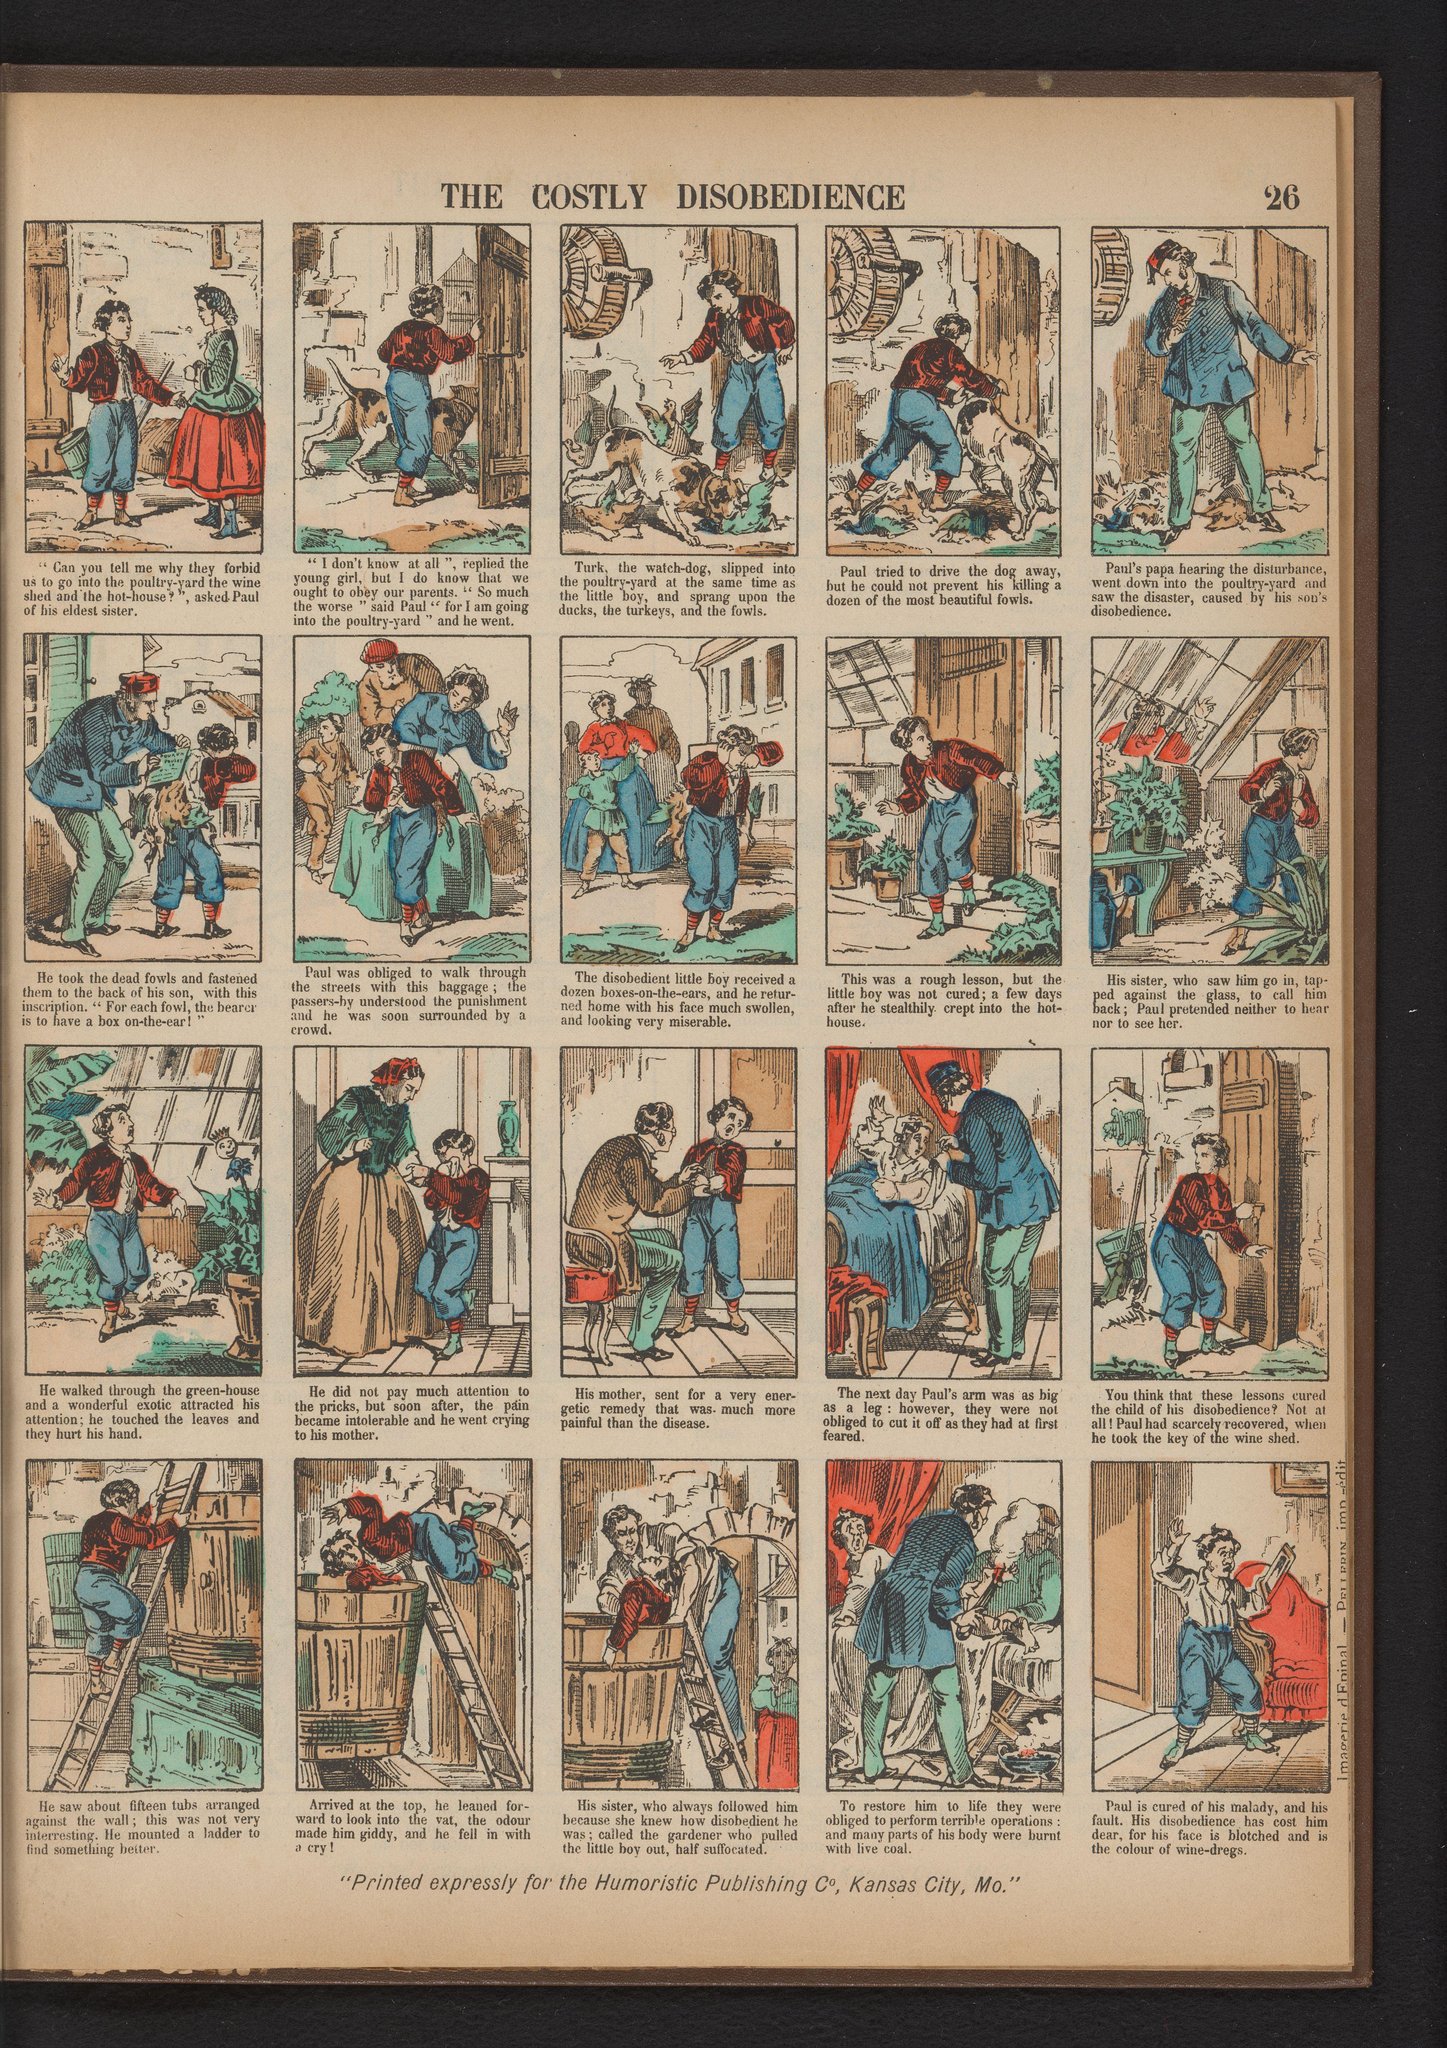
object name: print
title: Contes des fées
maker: Anonymous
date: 1893-1894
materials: paper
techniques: colour, letterpress printing, lithograph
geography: epinal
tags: obedience; 'obedienza' (ripa), boy (child between toddler and youth)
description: Blad met zestien voorstellingen over de lotgevallen van de ongehoorzame jongen Paul. Onder elke voorstelling een onderschrift in het Engels. Deze prent maakt deel uit van een album.